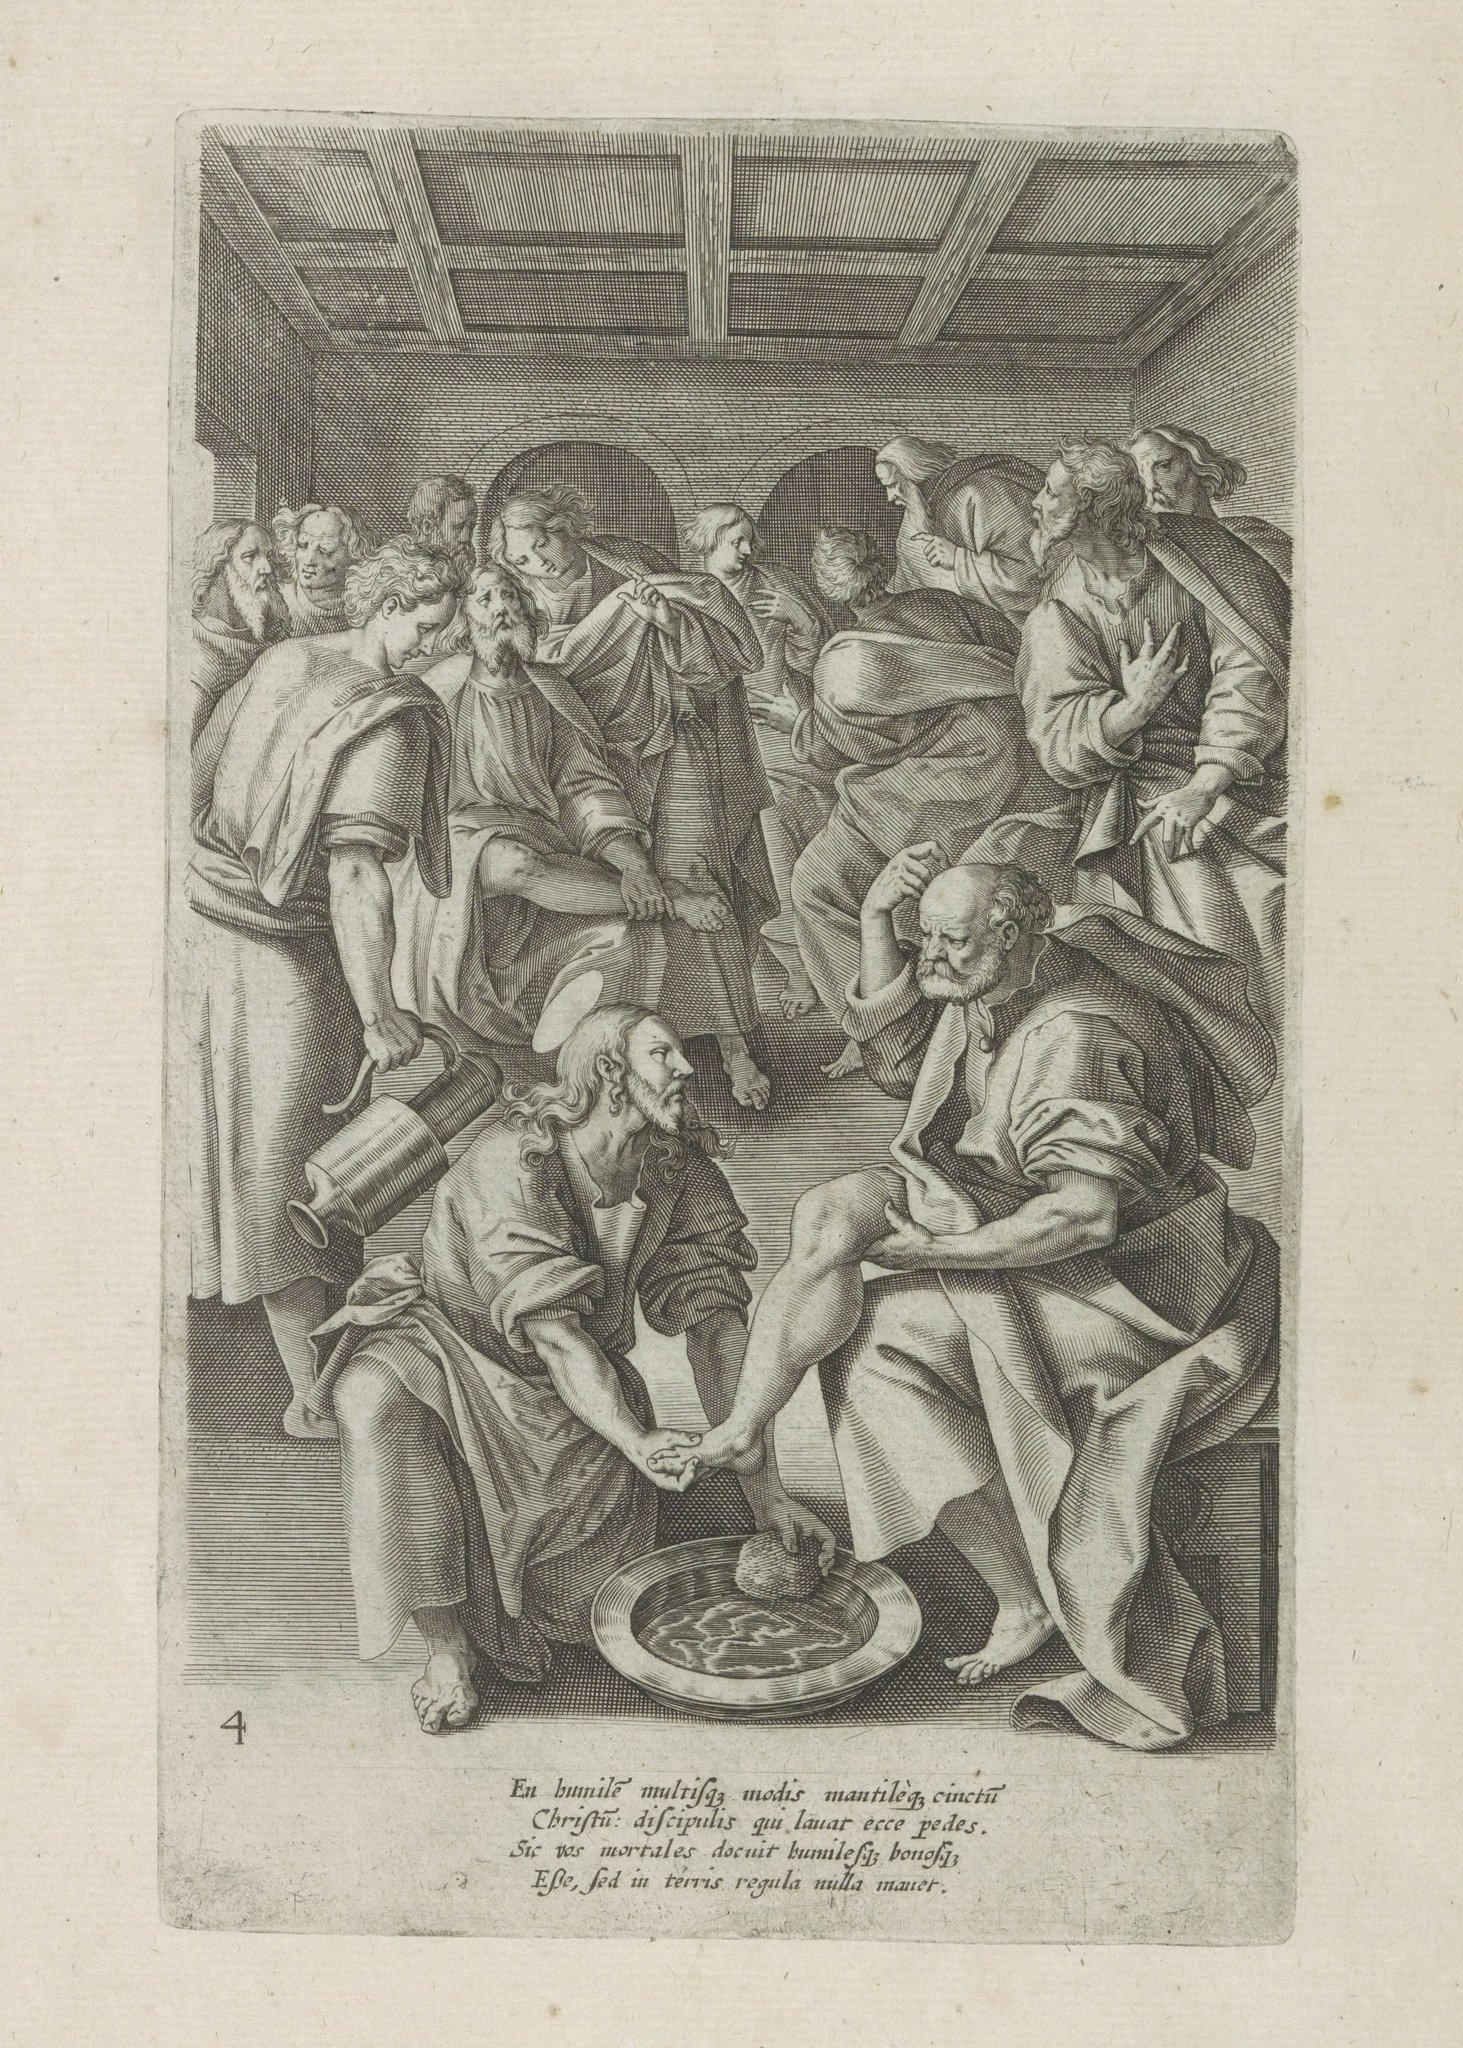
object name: album leaf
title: Voetwassing van Petrus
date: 1585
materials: paper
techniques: engraving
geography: antwerp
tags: christ washes peter's feet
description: Christus zit geknield voor de apostel Petrus en wast zijn voeten. Petrus protesteert. De andere apostelen staan blootvoets in het vertrek. Onder de voorstelling een vierregelig vers in het Latijn. Deze prent maakt deel uit van een album.